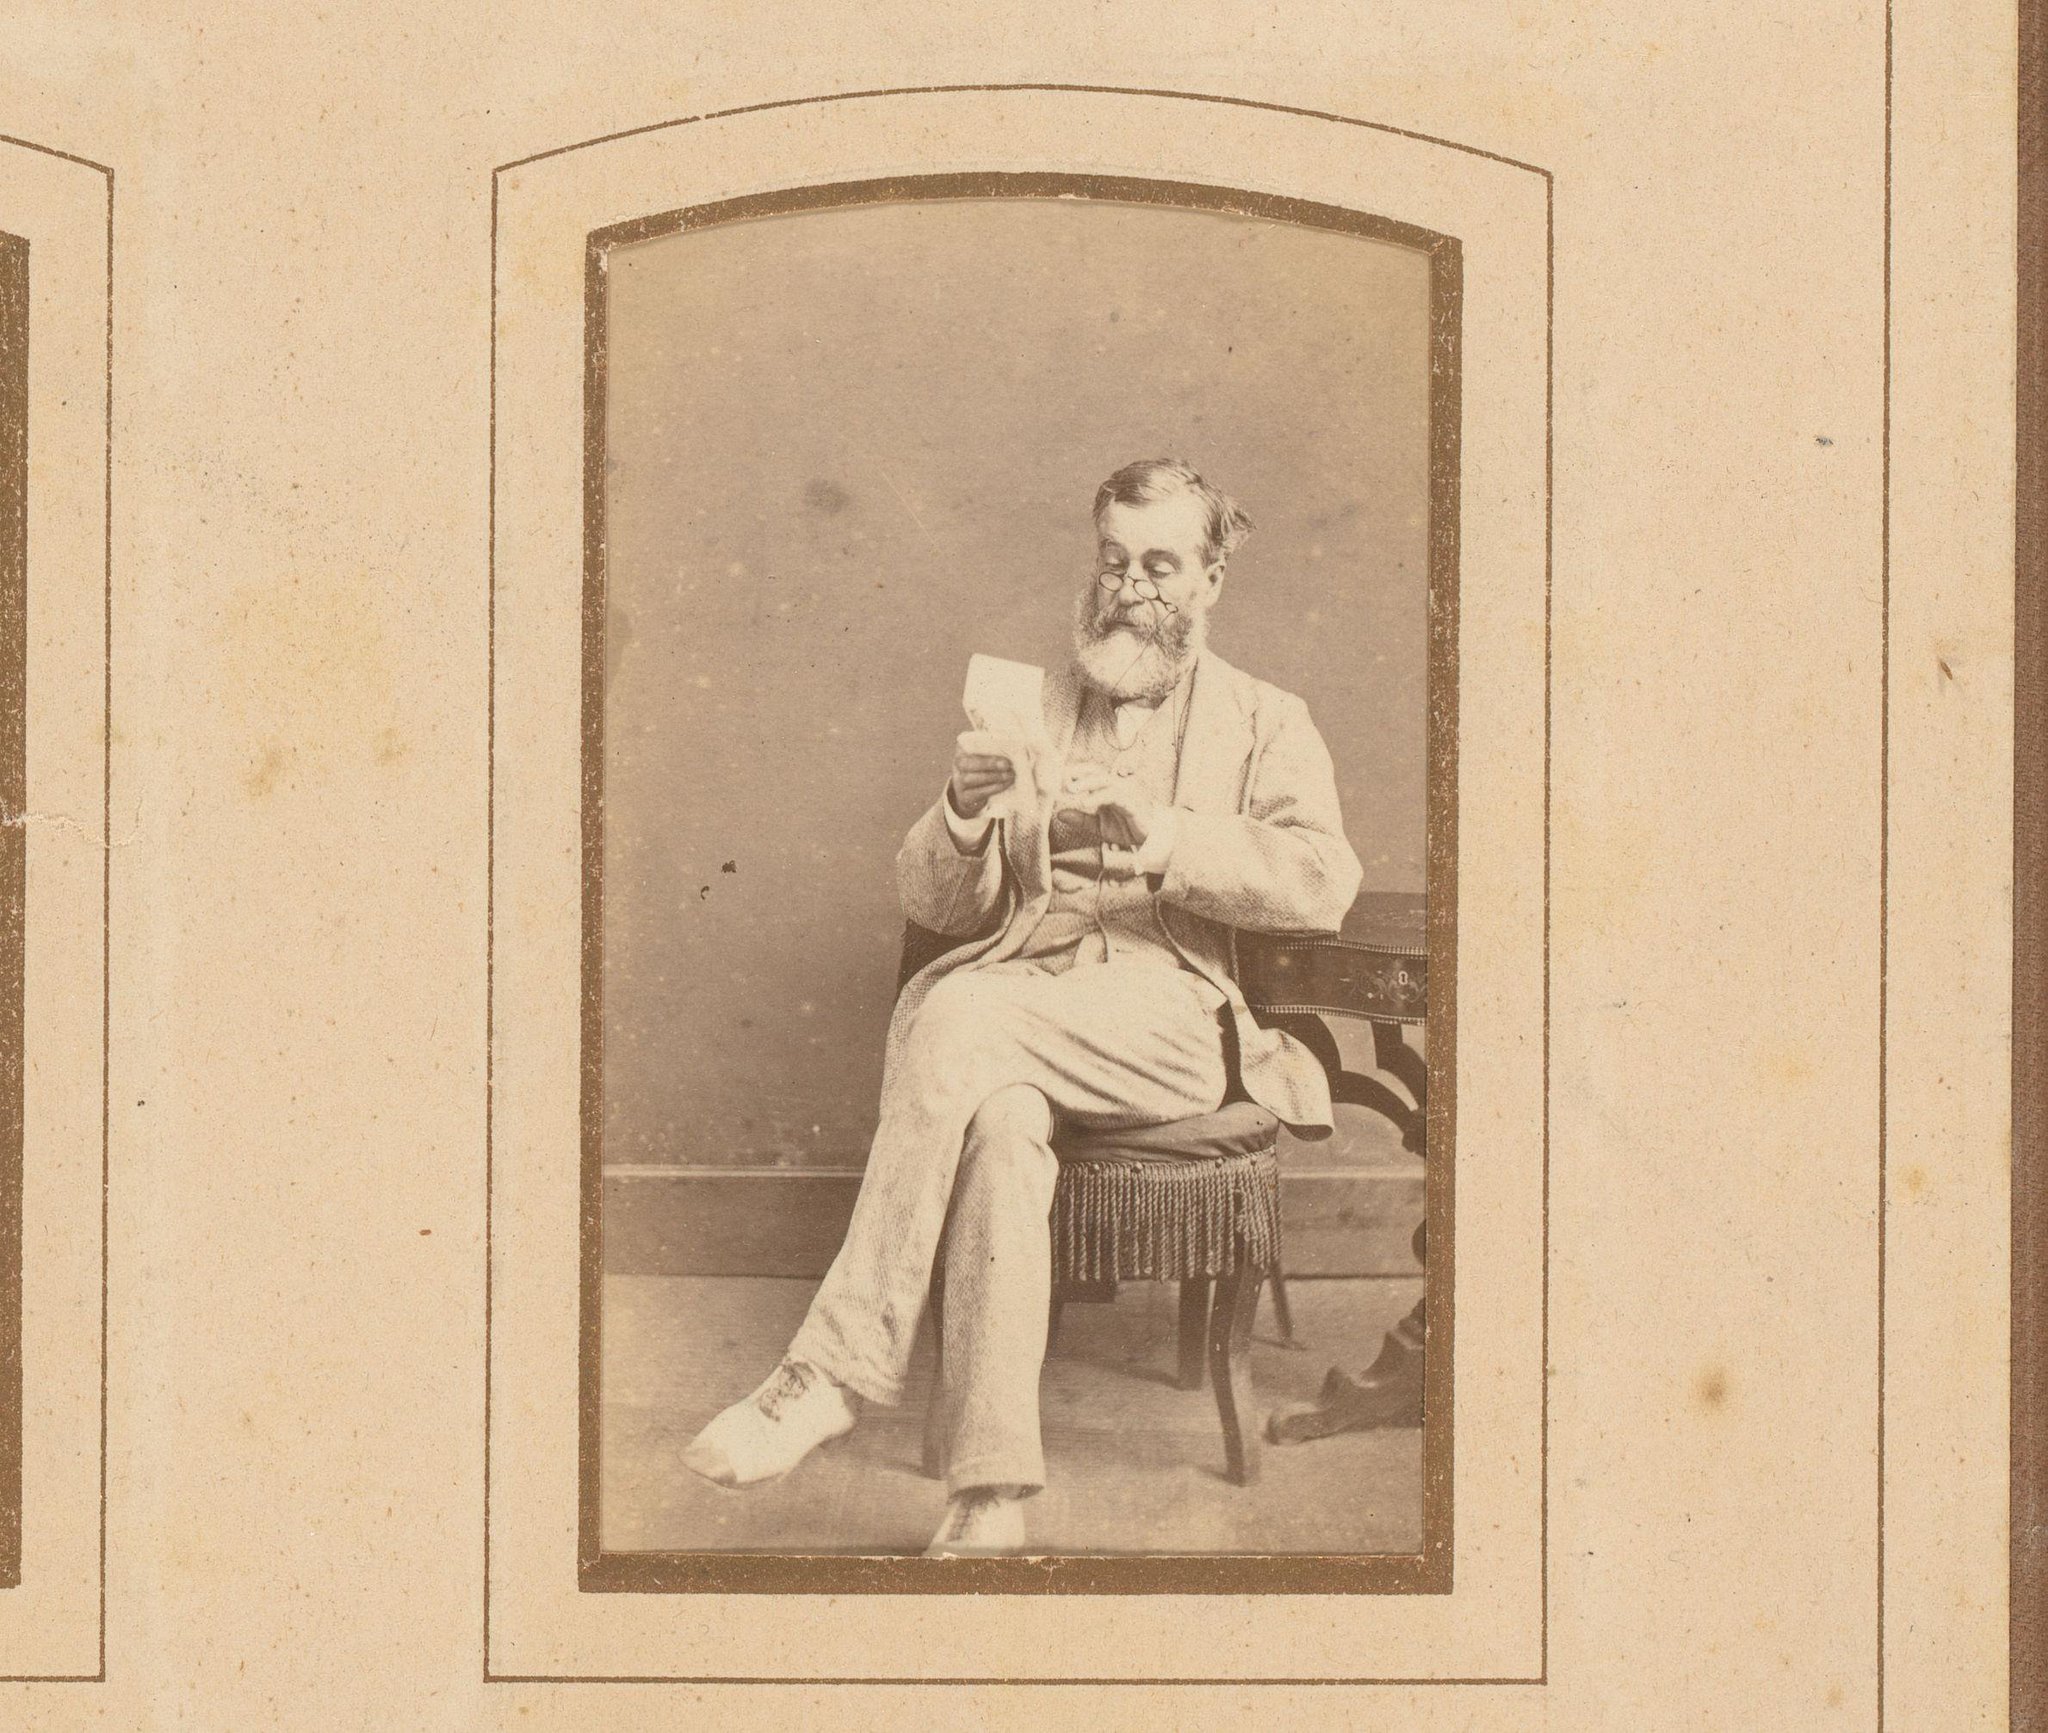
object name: photograph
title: Portret van een lezende man met bril, zittend aan een tafel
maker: anthony libert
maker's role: fotograaf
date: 1860-1880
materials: cardboard, photographic support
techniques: albumen print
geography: trinidad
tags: eyeglasses, spectacles, sitting figure, reading, historical persons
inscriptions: inscription: ‘ANTHy LIBERT/ TRINIDAD./ STEREO & OTHER VIEWS OF THE/ WEST INDIES.’